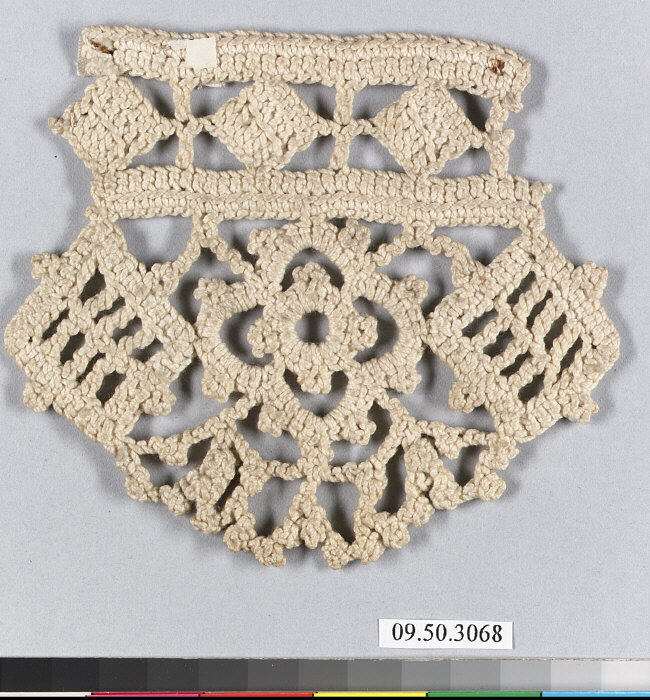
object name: sample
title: Crochet Work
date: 1801-1900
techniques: crochet